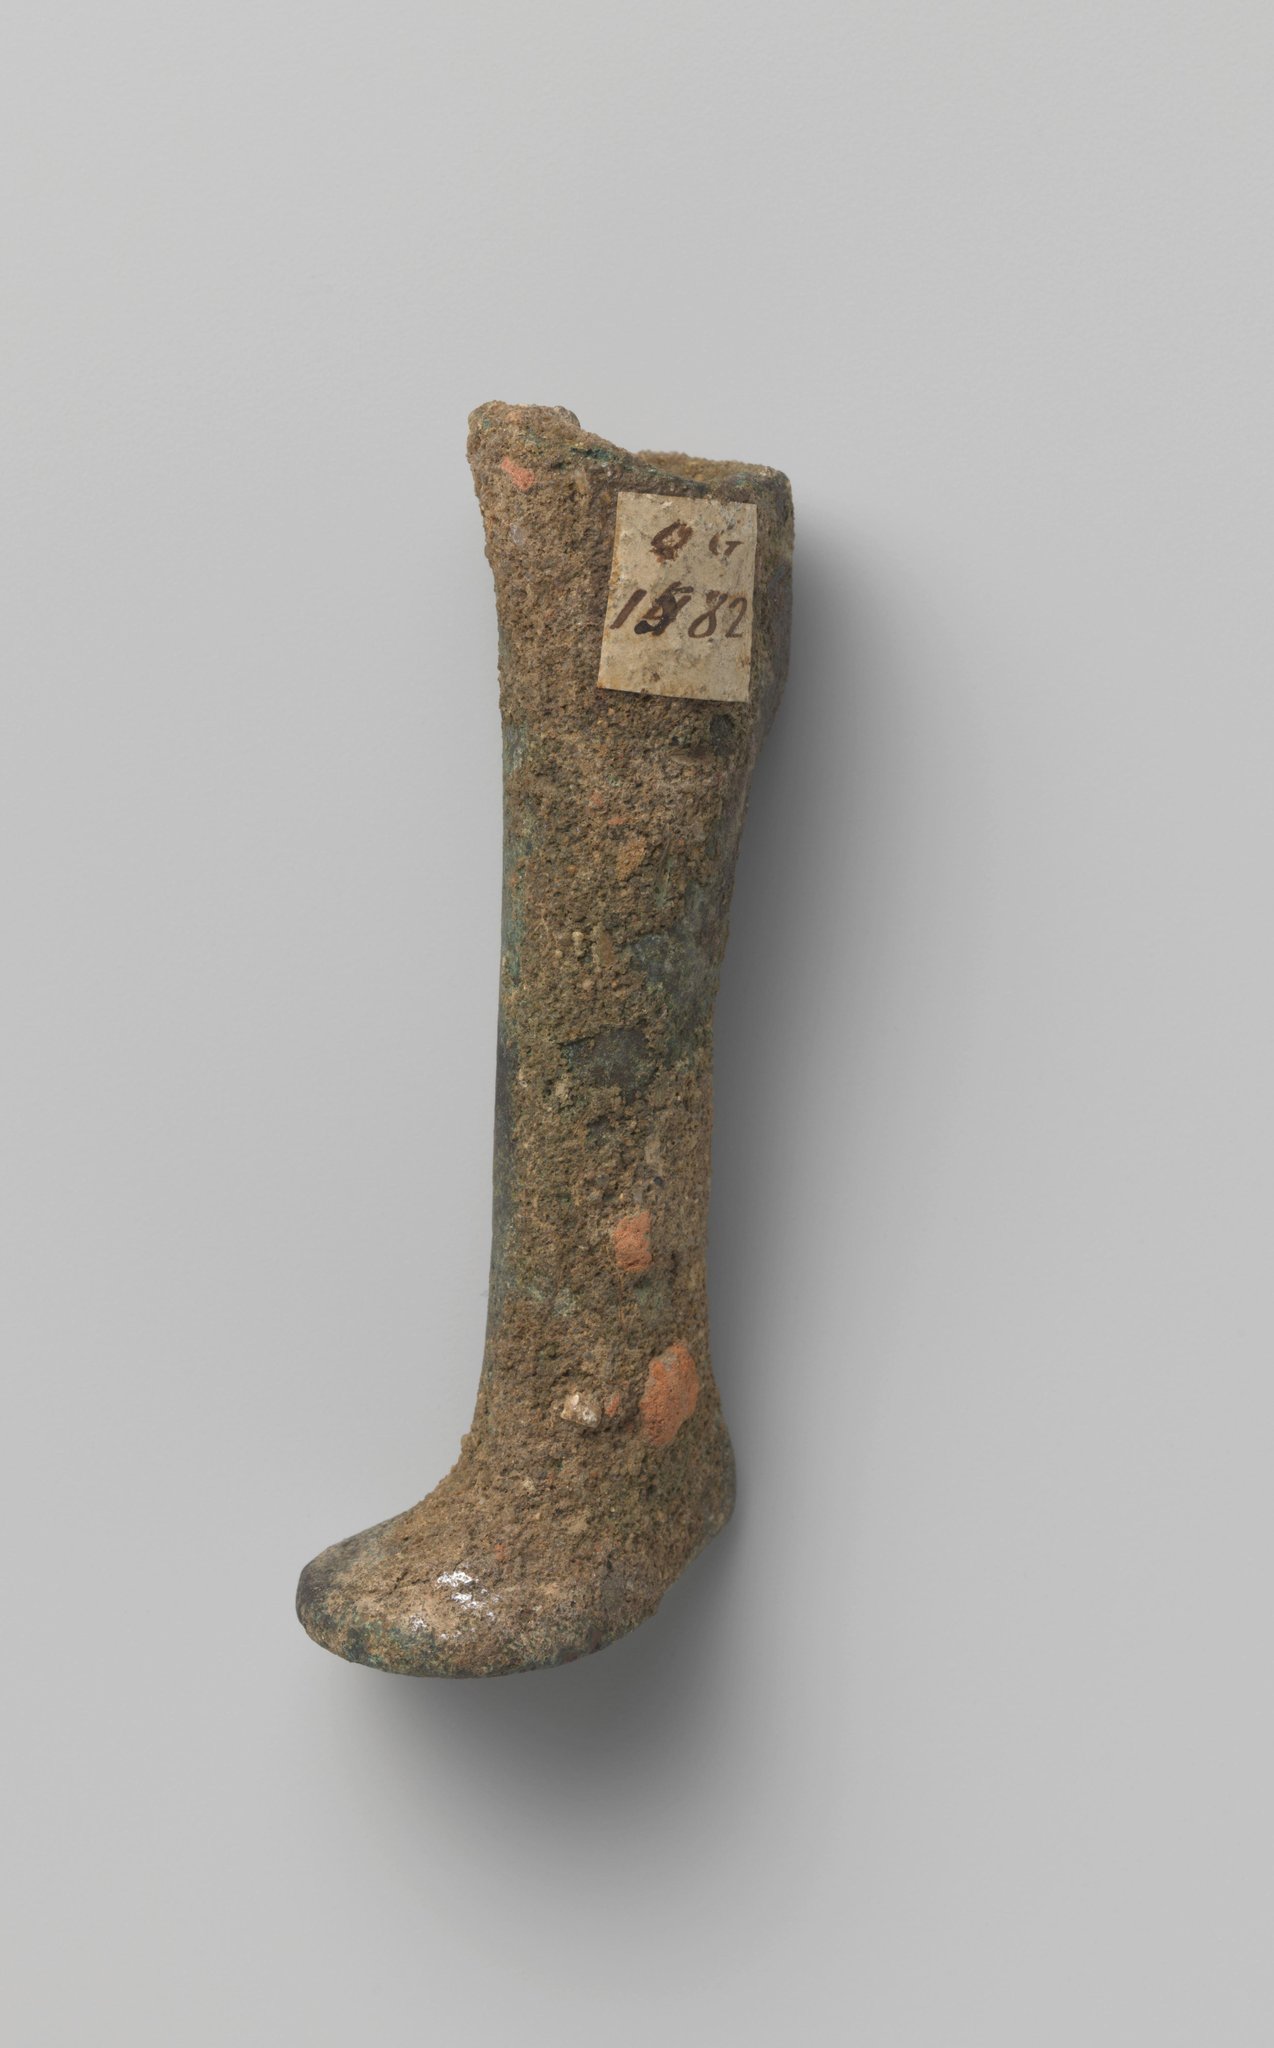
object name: ewer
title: Bronzen voet van een kan of kookpot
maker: Anonymous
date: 1300-1500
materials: bronze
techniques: casting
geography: low countries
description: Bronzen voet van een kan of kookpot. Aan de bovenzijde hol.